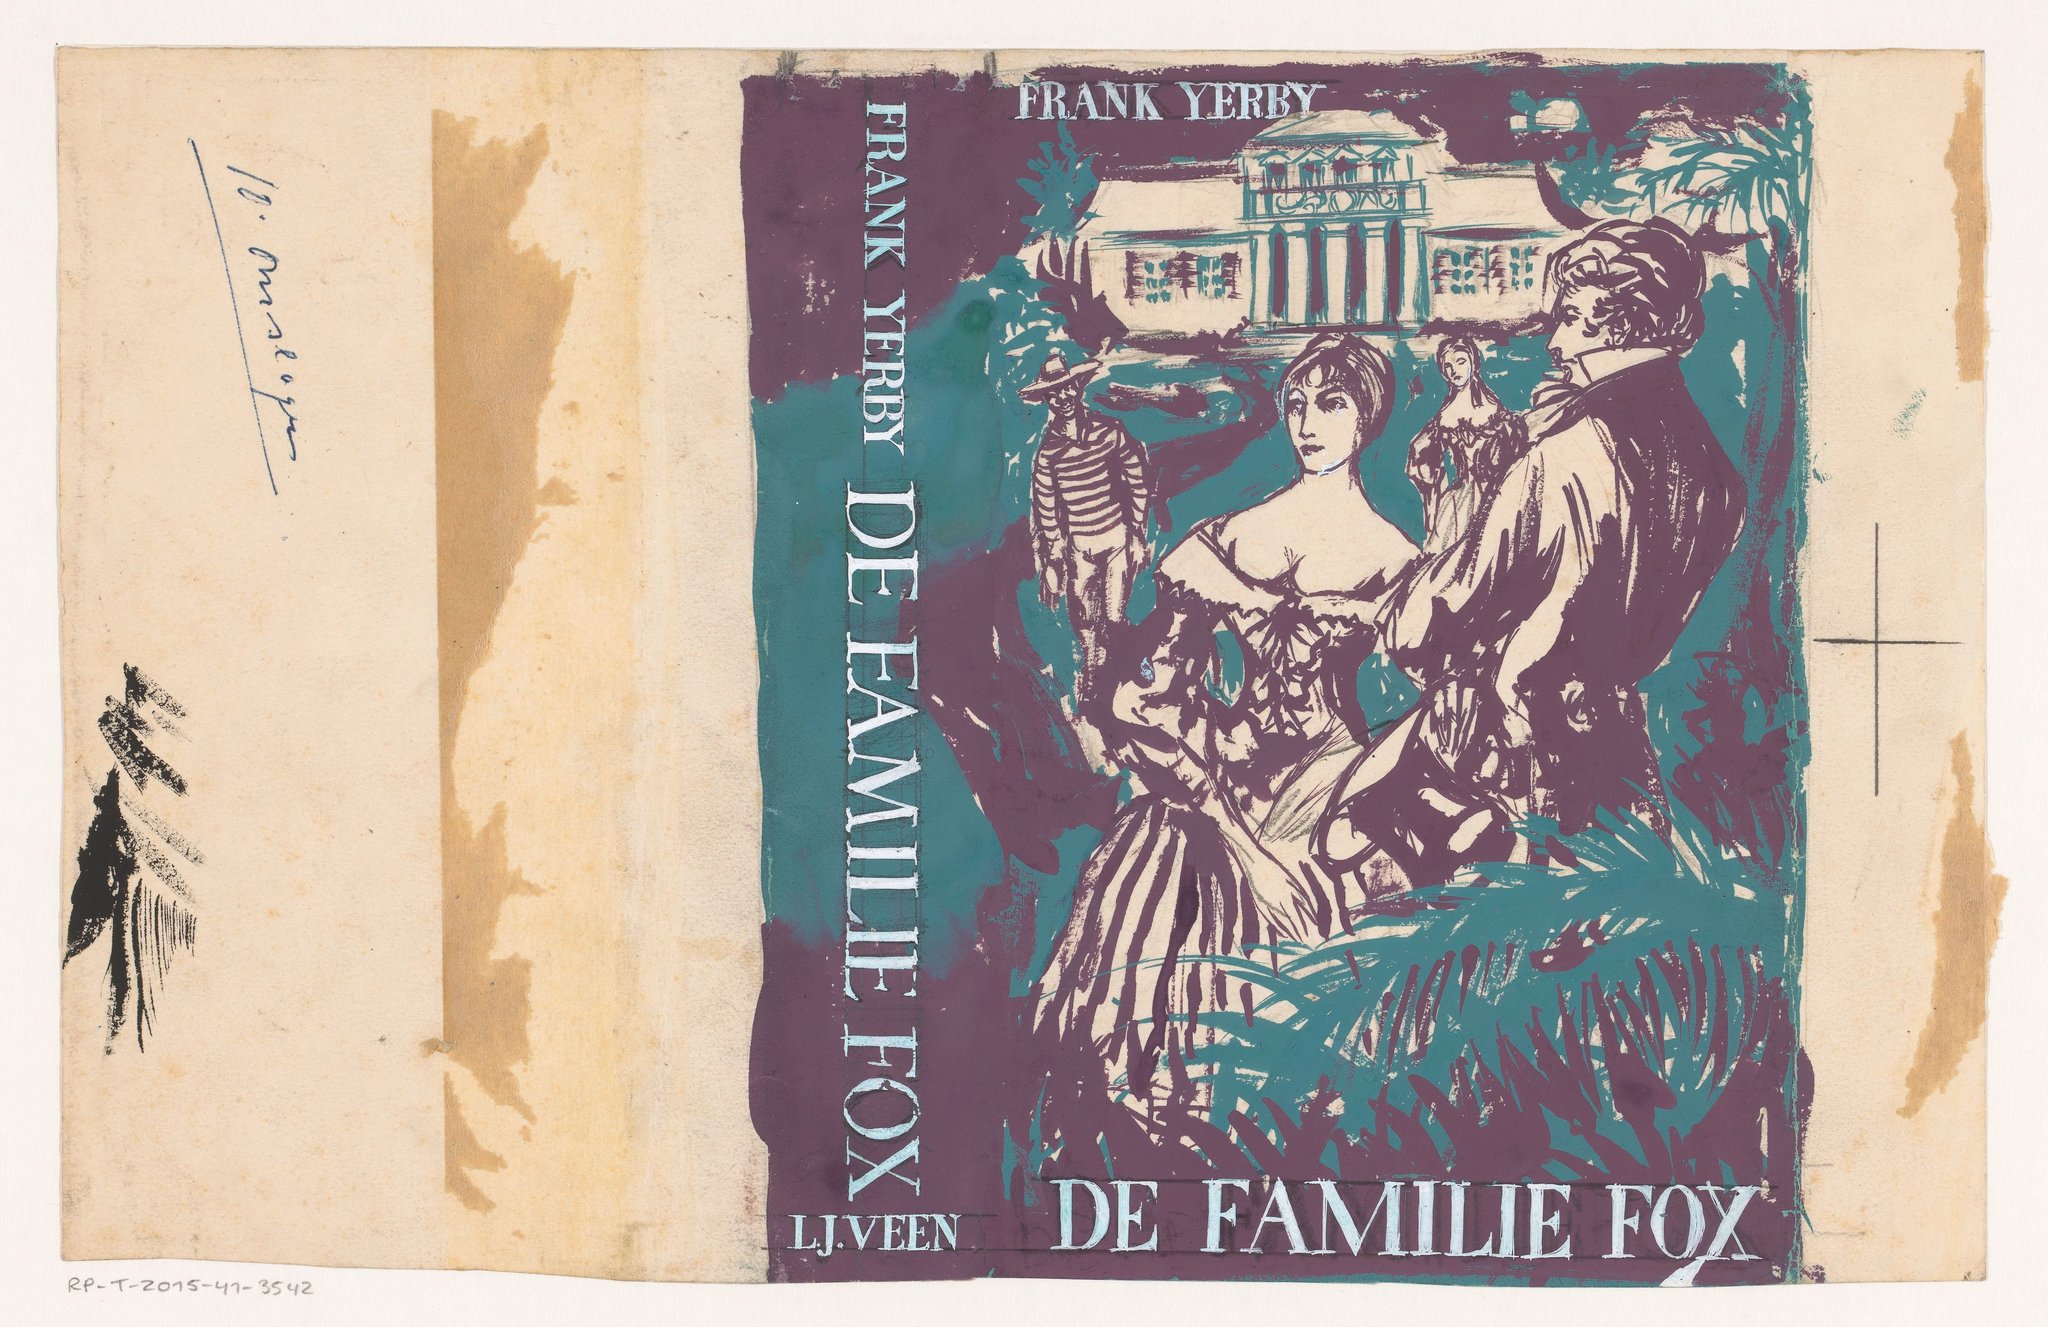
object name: study for binding design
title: Bandontwerp voor: Frank Yerby, De familie Fox, c. 1948-1957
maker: Anonymous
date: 1948-1957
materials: paint, paper, pencil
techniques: brush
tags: marriage, married couple, 'matrimonium', country-house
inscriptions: annotation: ‘10 omslagen’, collector's mark: Lugt 2228a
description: Voor een landhuis staan vier figuren, onder wie Stephen Fox en zijn echtgenote Lilli D'Arceneaux.